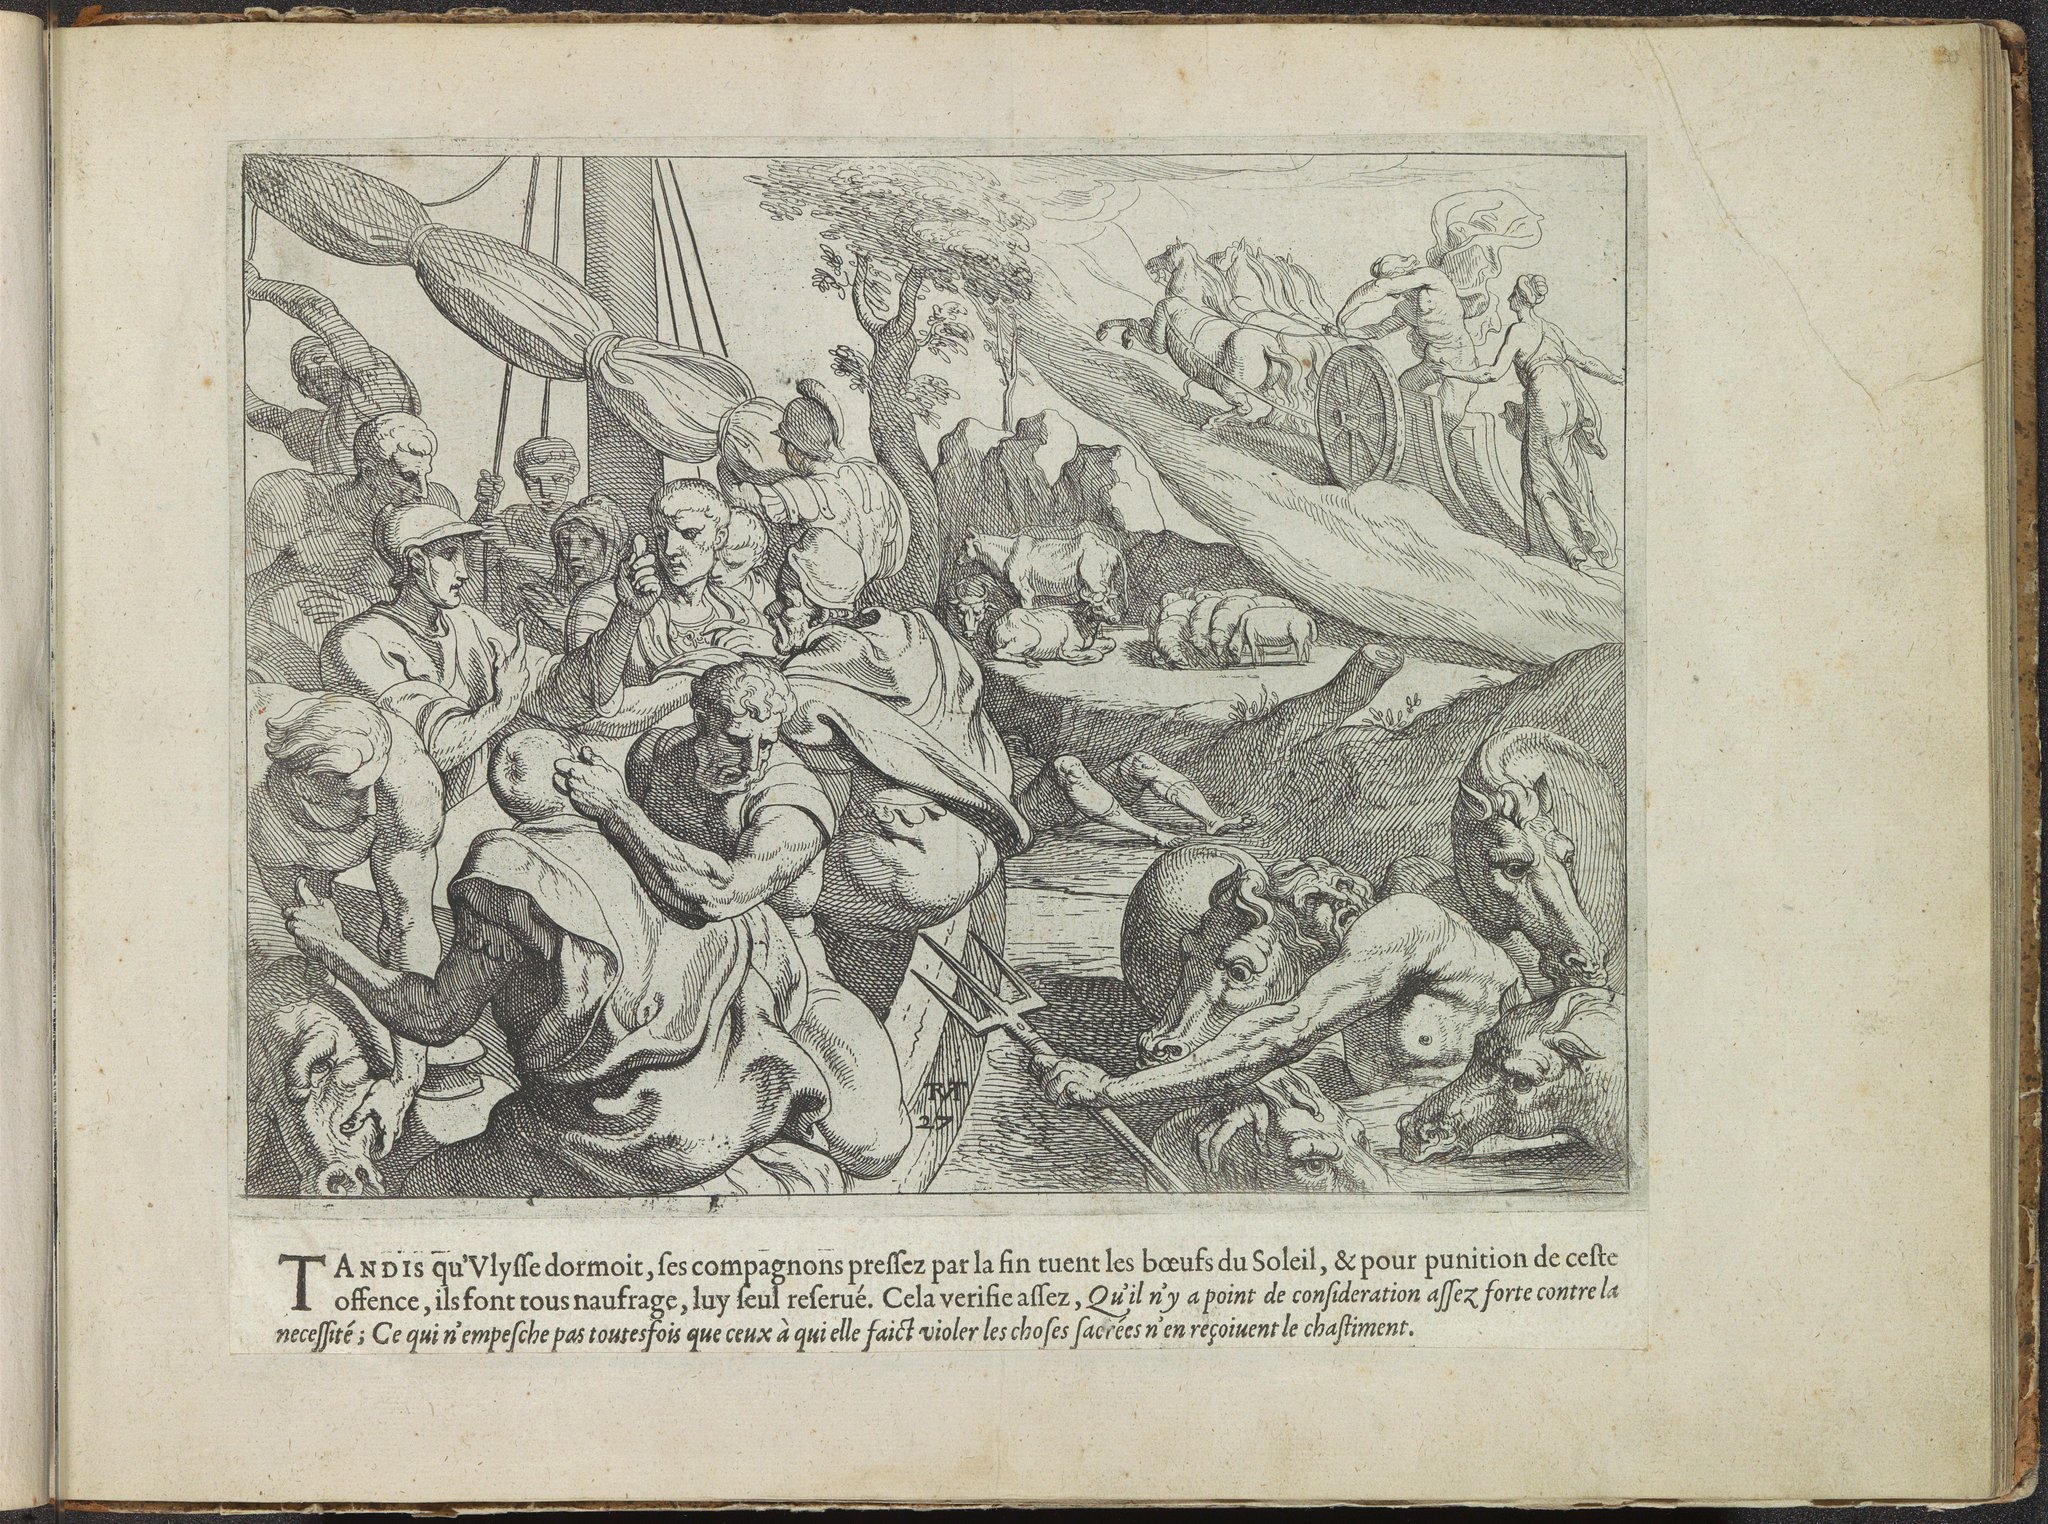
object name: print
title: Les Travaux d'Ulysse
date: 1633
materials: paper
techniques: engraving, etching, letterpress printing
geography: paris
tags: in thrinacria ulysses' men devour some of the cattle of the sun-god while ulysses is asleep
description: De hongerige metgezellen van Odysseus slachten aan boord een van de runderen van de zonnegod Helios. Op de achtergrond de runderen en Helios in zijn wagen. Op de voorgrond bedreigt Neptunus het schip. De prent maakt deel uit van een album.